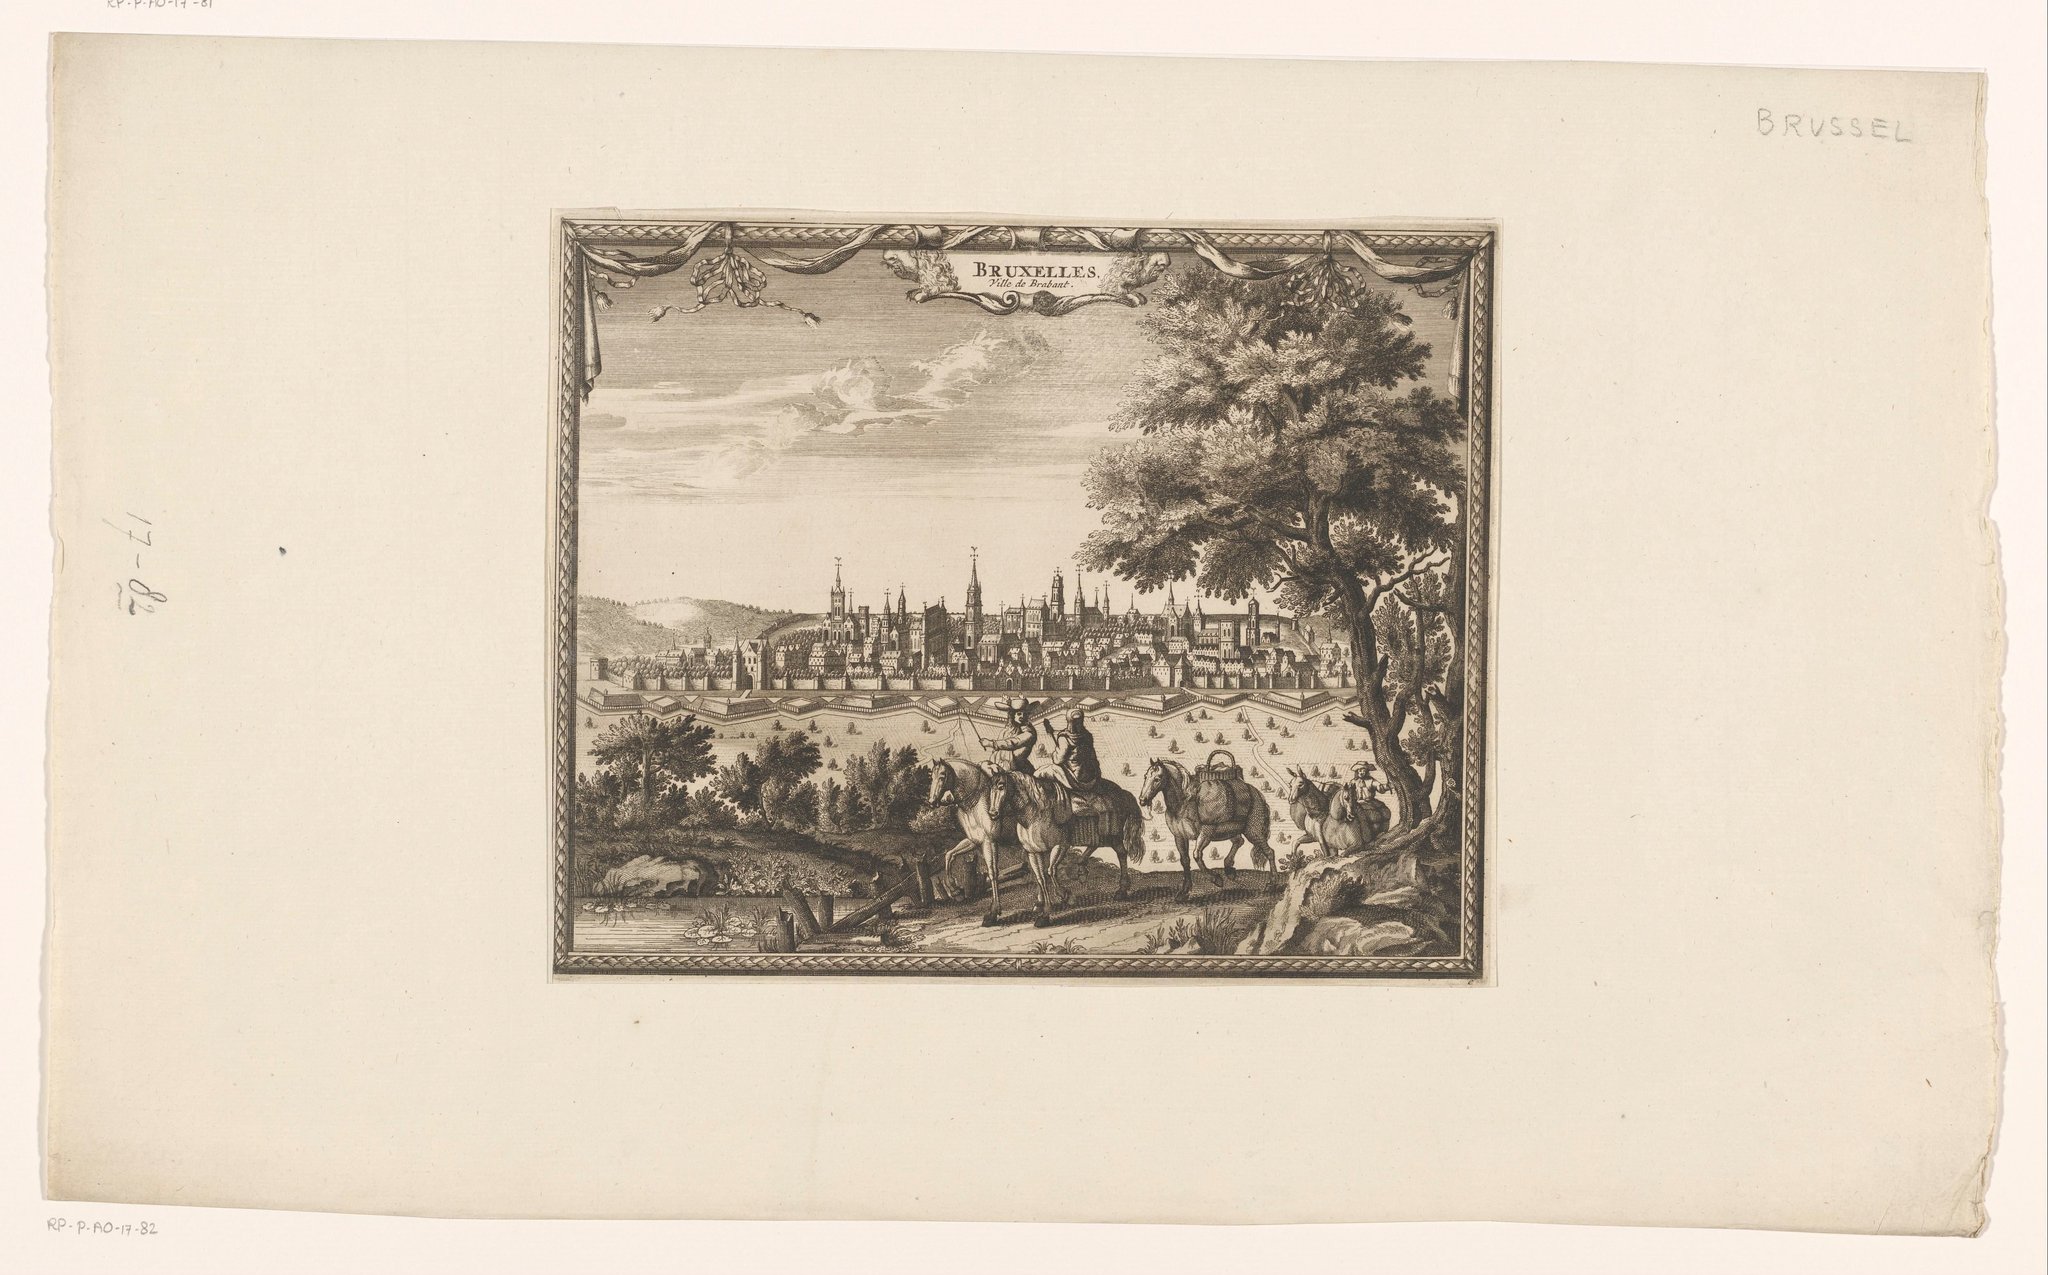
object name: print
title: Bruxelles, ville de Brabant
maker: Anonymous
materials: paper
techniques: etching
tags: church (exterior), fortified city, prospect of city, town panorama, silhouette of city, brussels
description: Huidige staat van prent ook gebruikt in: Aa, Pieter van der. Europa. Leiden: Pieter van der Aa, s.a. [ca. 1715]. En in: Afbeeldinghe der voornaemste steeden van Nederlant / Les principales villes des Pais-bas. Amsteram: Covens & Mortier, s.a. [na 1721]. En in: Les forces de l'Europe, Asie, Afrique et Amerique, ou description des principales villes, avec leurs fortifications (…). 20 delen. Leiden : Pieter van der Aa, 1726. Huidige staat met apart gedrukte sierrand gebruikt in: Aa, Pieter van der. La galerie agreable du monde (...). 66 delen. Leiden: Pieter van der Aa, 1728, dl. 16.